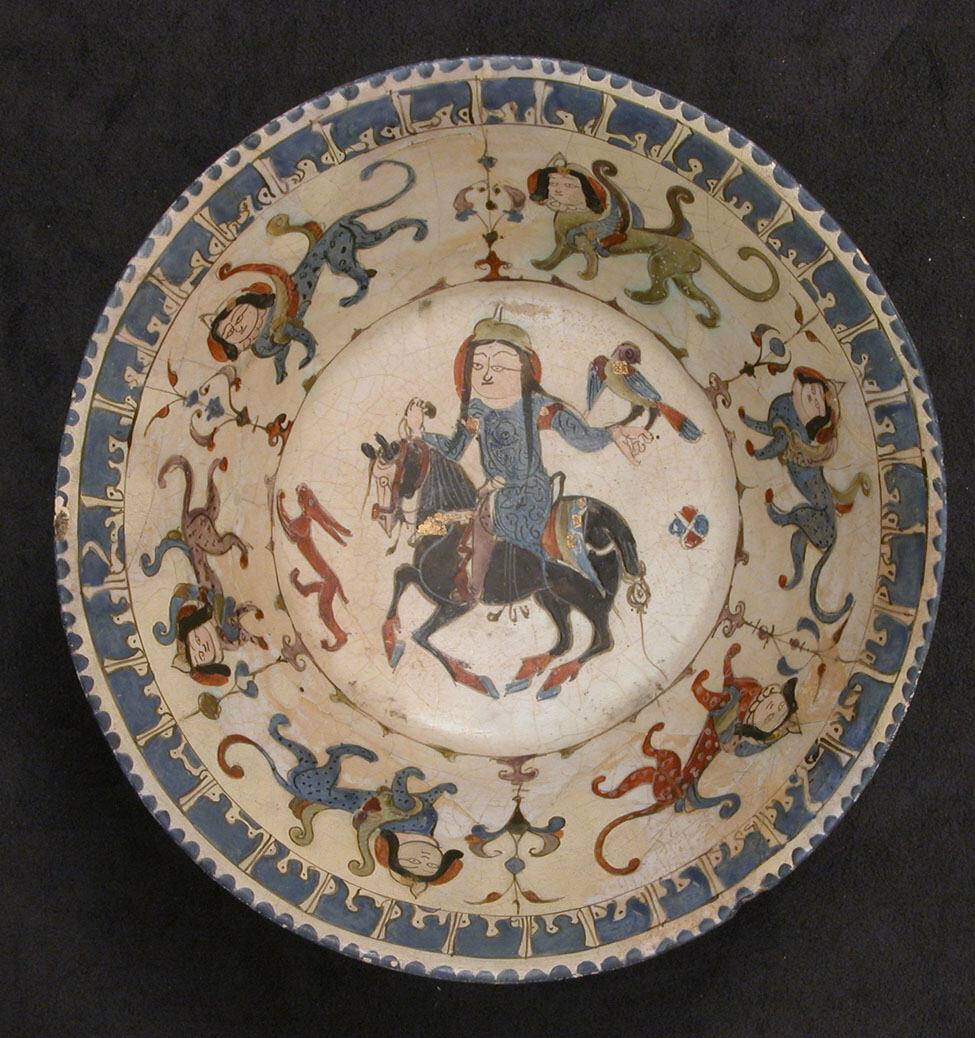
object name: bowl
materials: glaze, stonepaste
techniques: gilding, overglaze, painting, polychrome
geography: iran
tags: birds,men,sphinx,horses